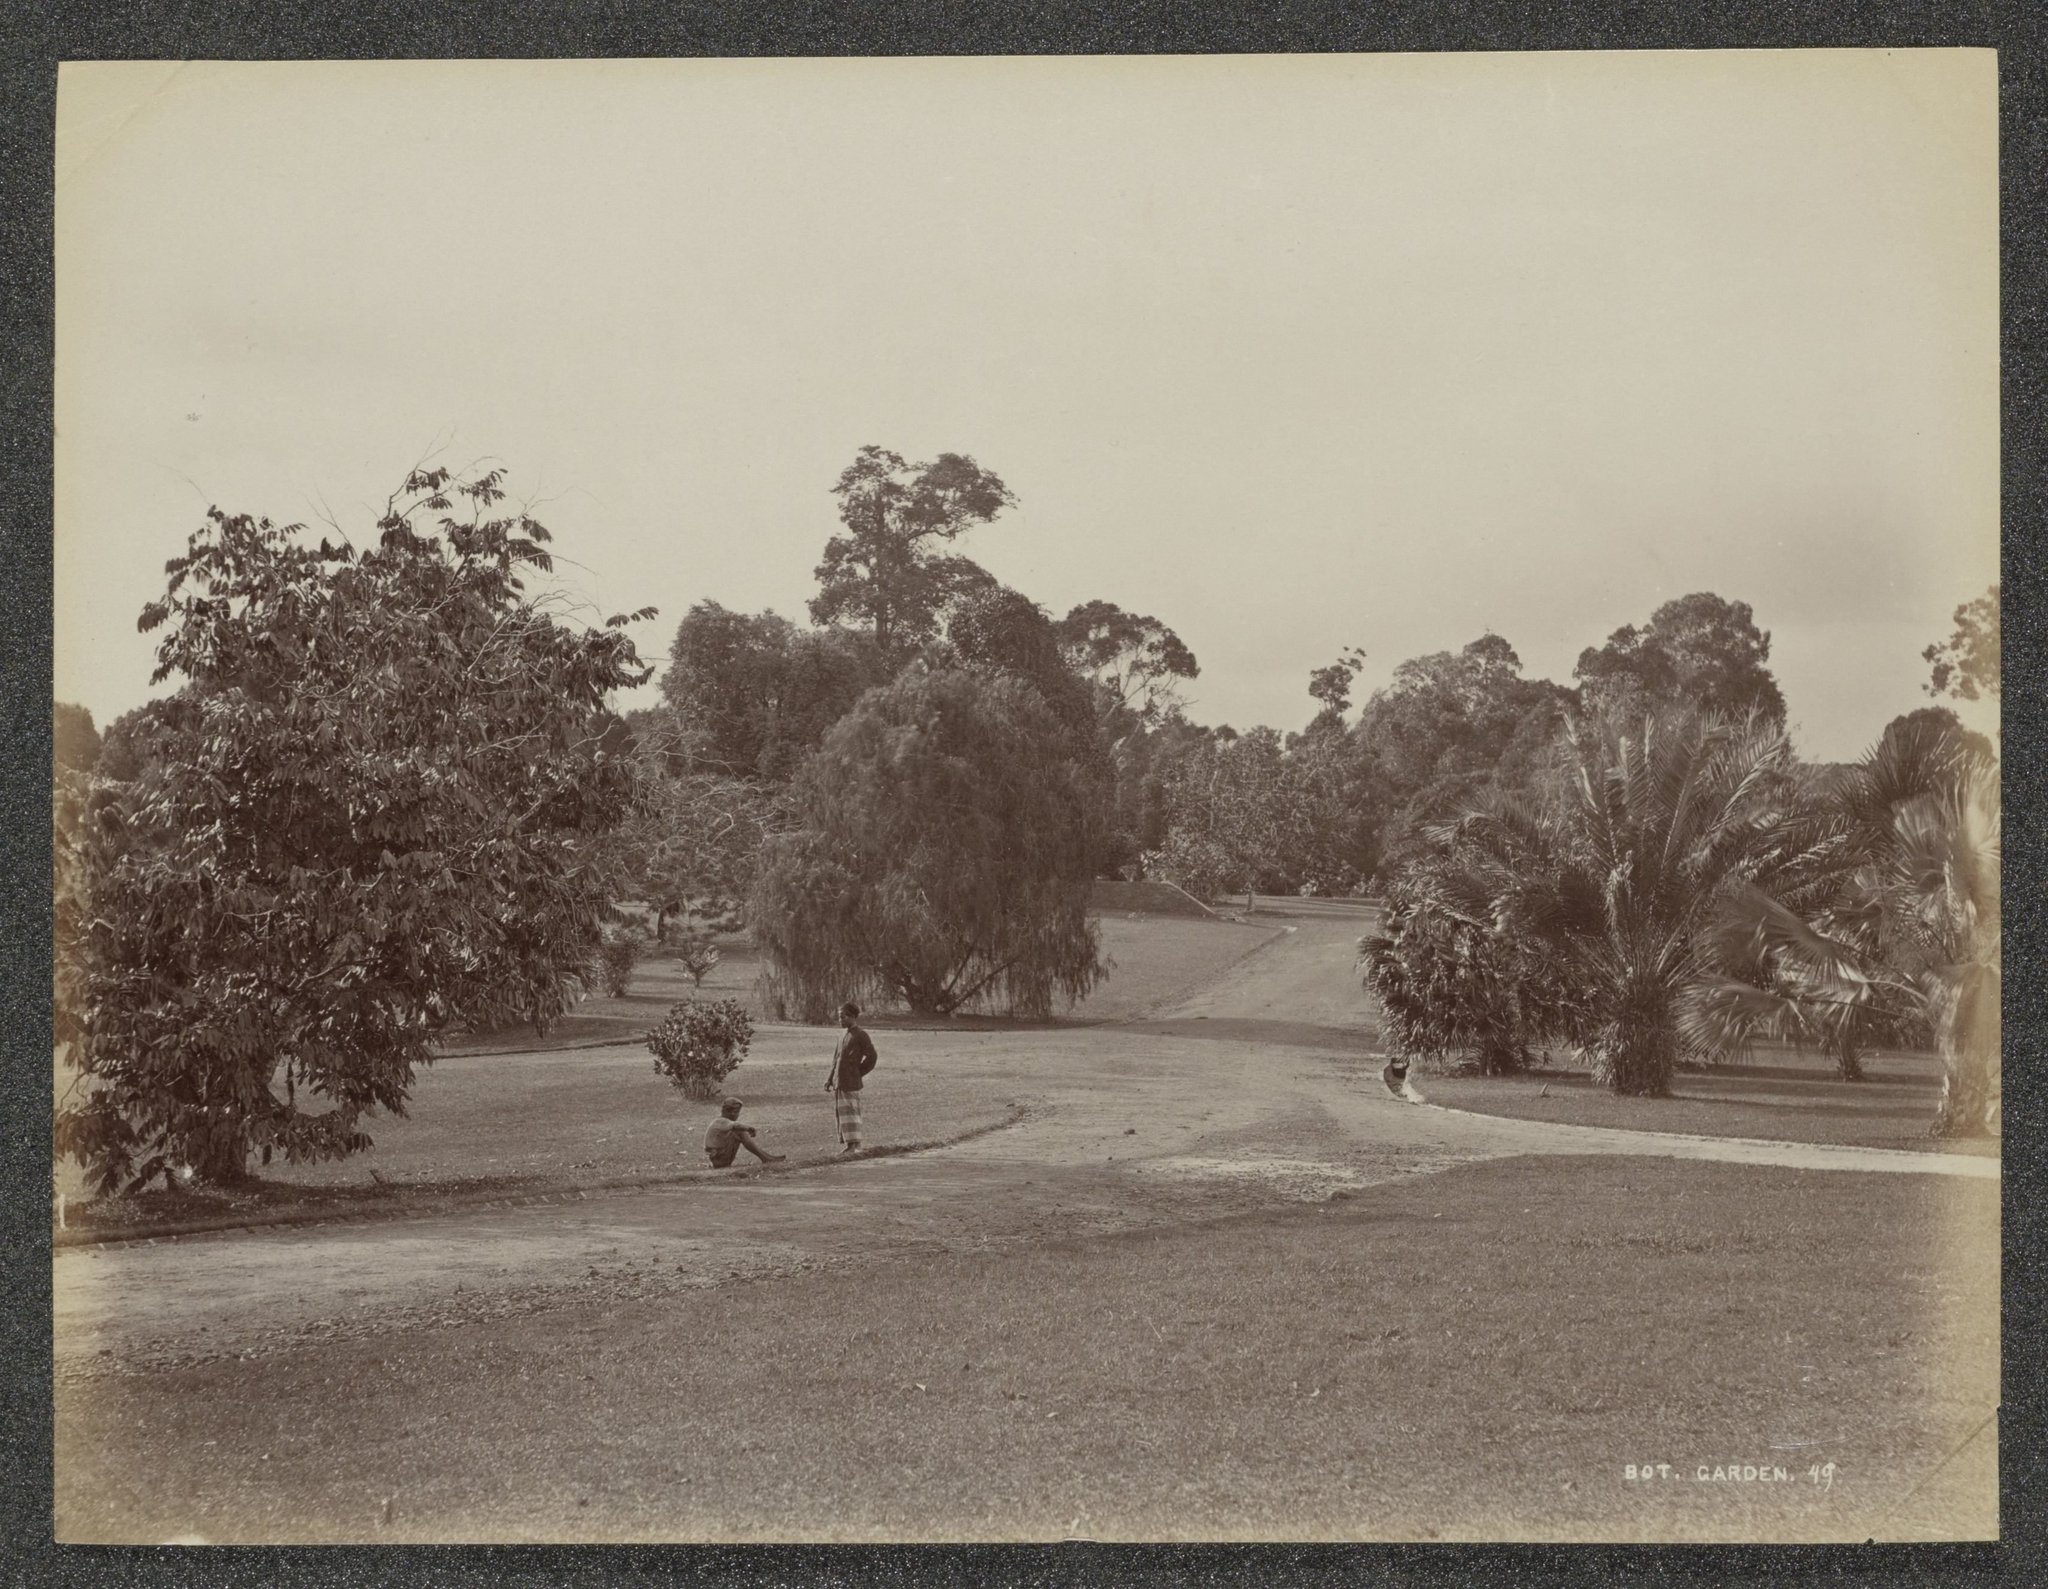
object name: album leaf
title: Vrouw en een jongen in de botanische tuin van (vermoedelijk) Singapore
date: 1870-1900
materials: paper, photographic support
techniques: albumen print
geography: singapore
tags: botanic garden, 'hortus botanicus', singapore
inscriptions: negative number: ‘49’, check stamp: ‘G.R. Lambert Singapore’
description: Onderdeel van Album met 50 foto's van een reis door Zuidoost-Azië.